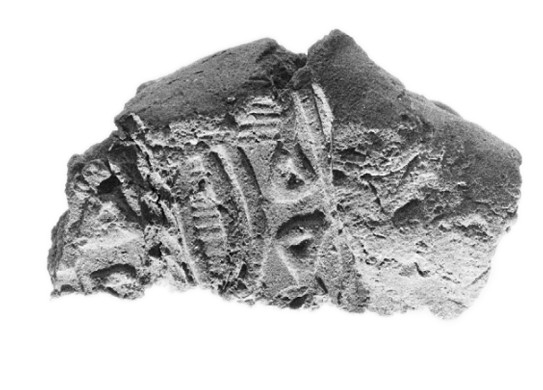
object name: sealing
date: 1981-1640 BCE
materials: mud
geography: egypt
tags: hieroglyphs